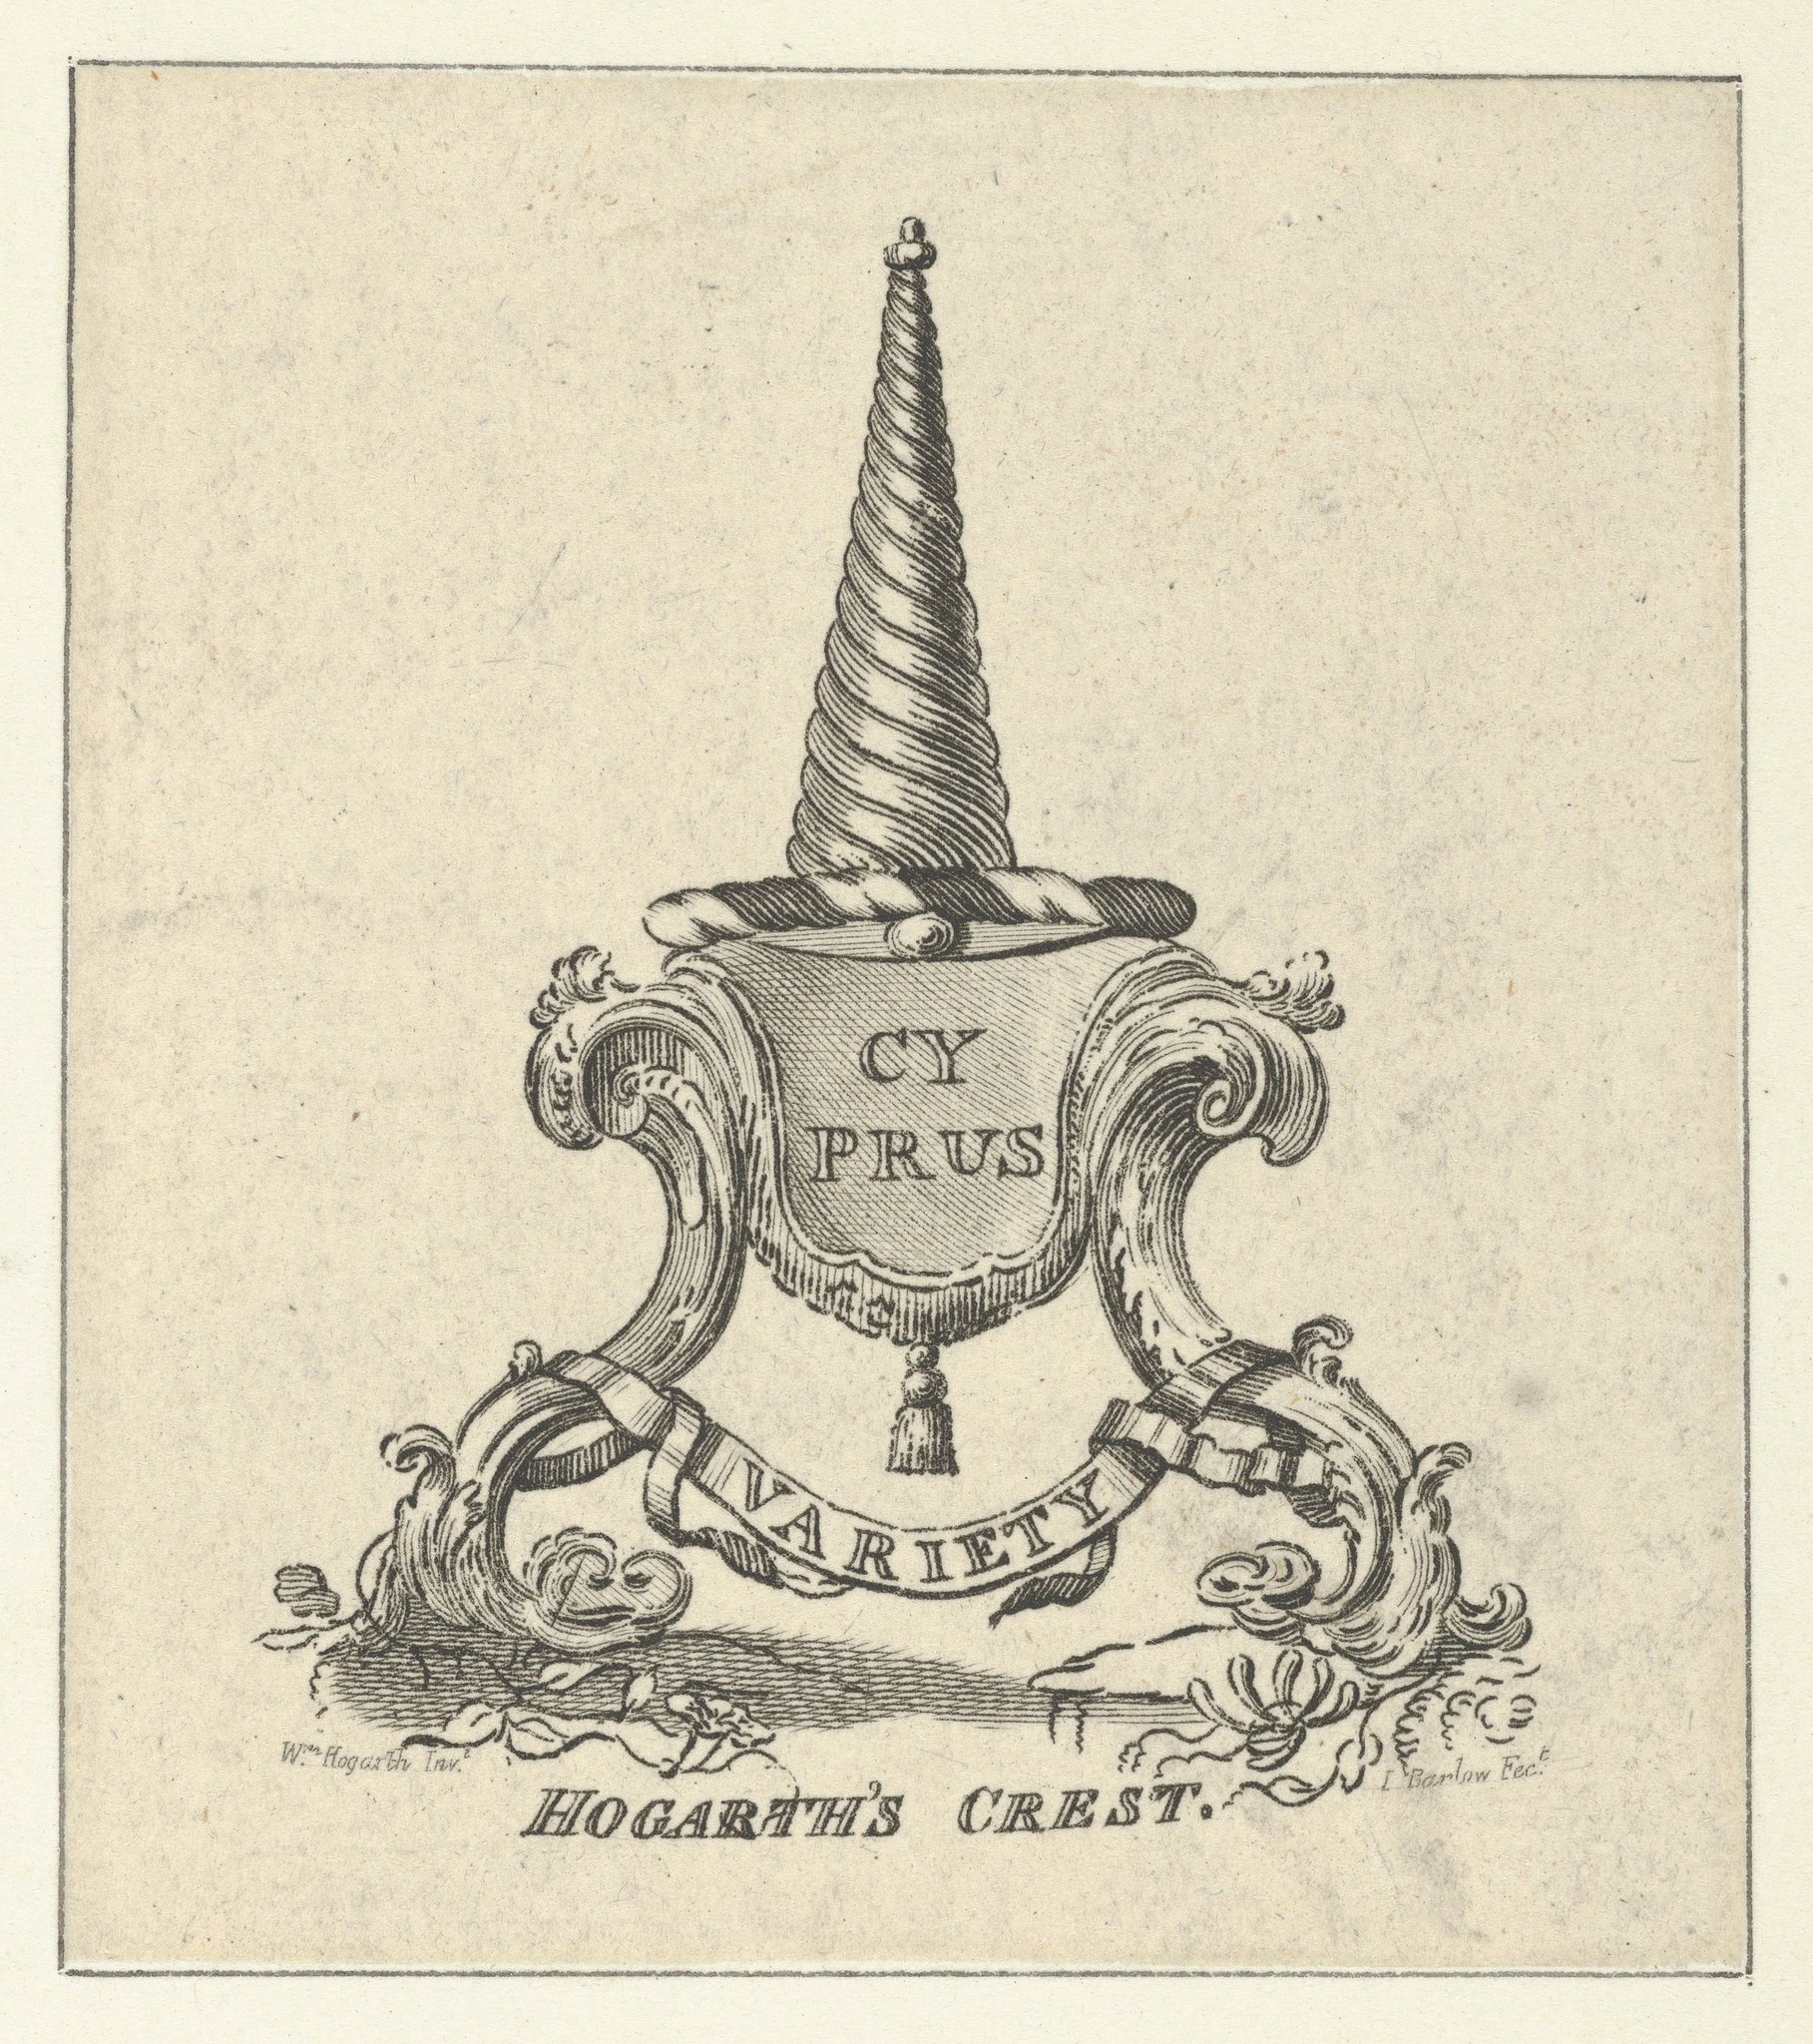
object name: print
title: Hogarth's Crest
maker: john barlow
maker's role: etcher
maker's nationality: british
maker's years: 1759-1815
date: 1782-1800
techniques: engraving, etching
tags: insignia